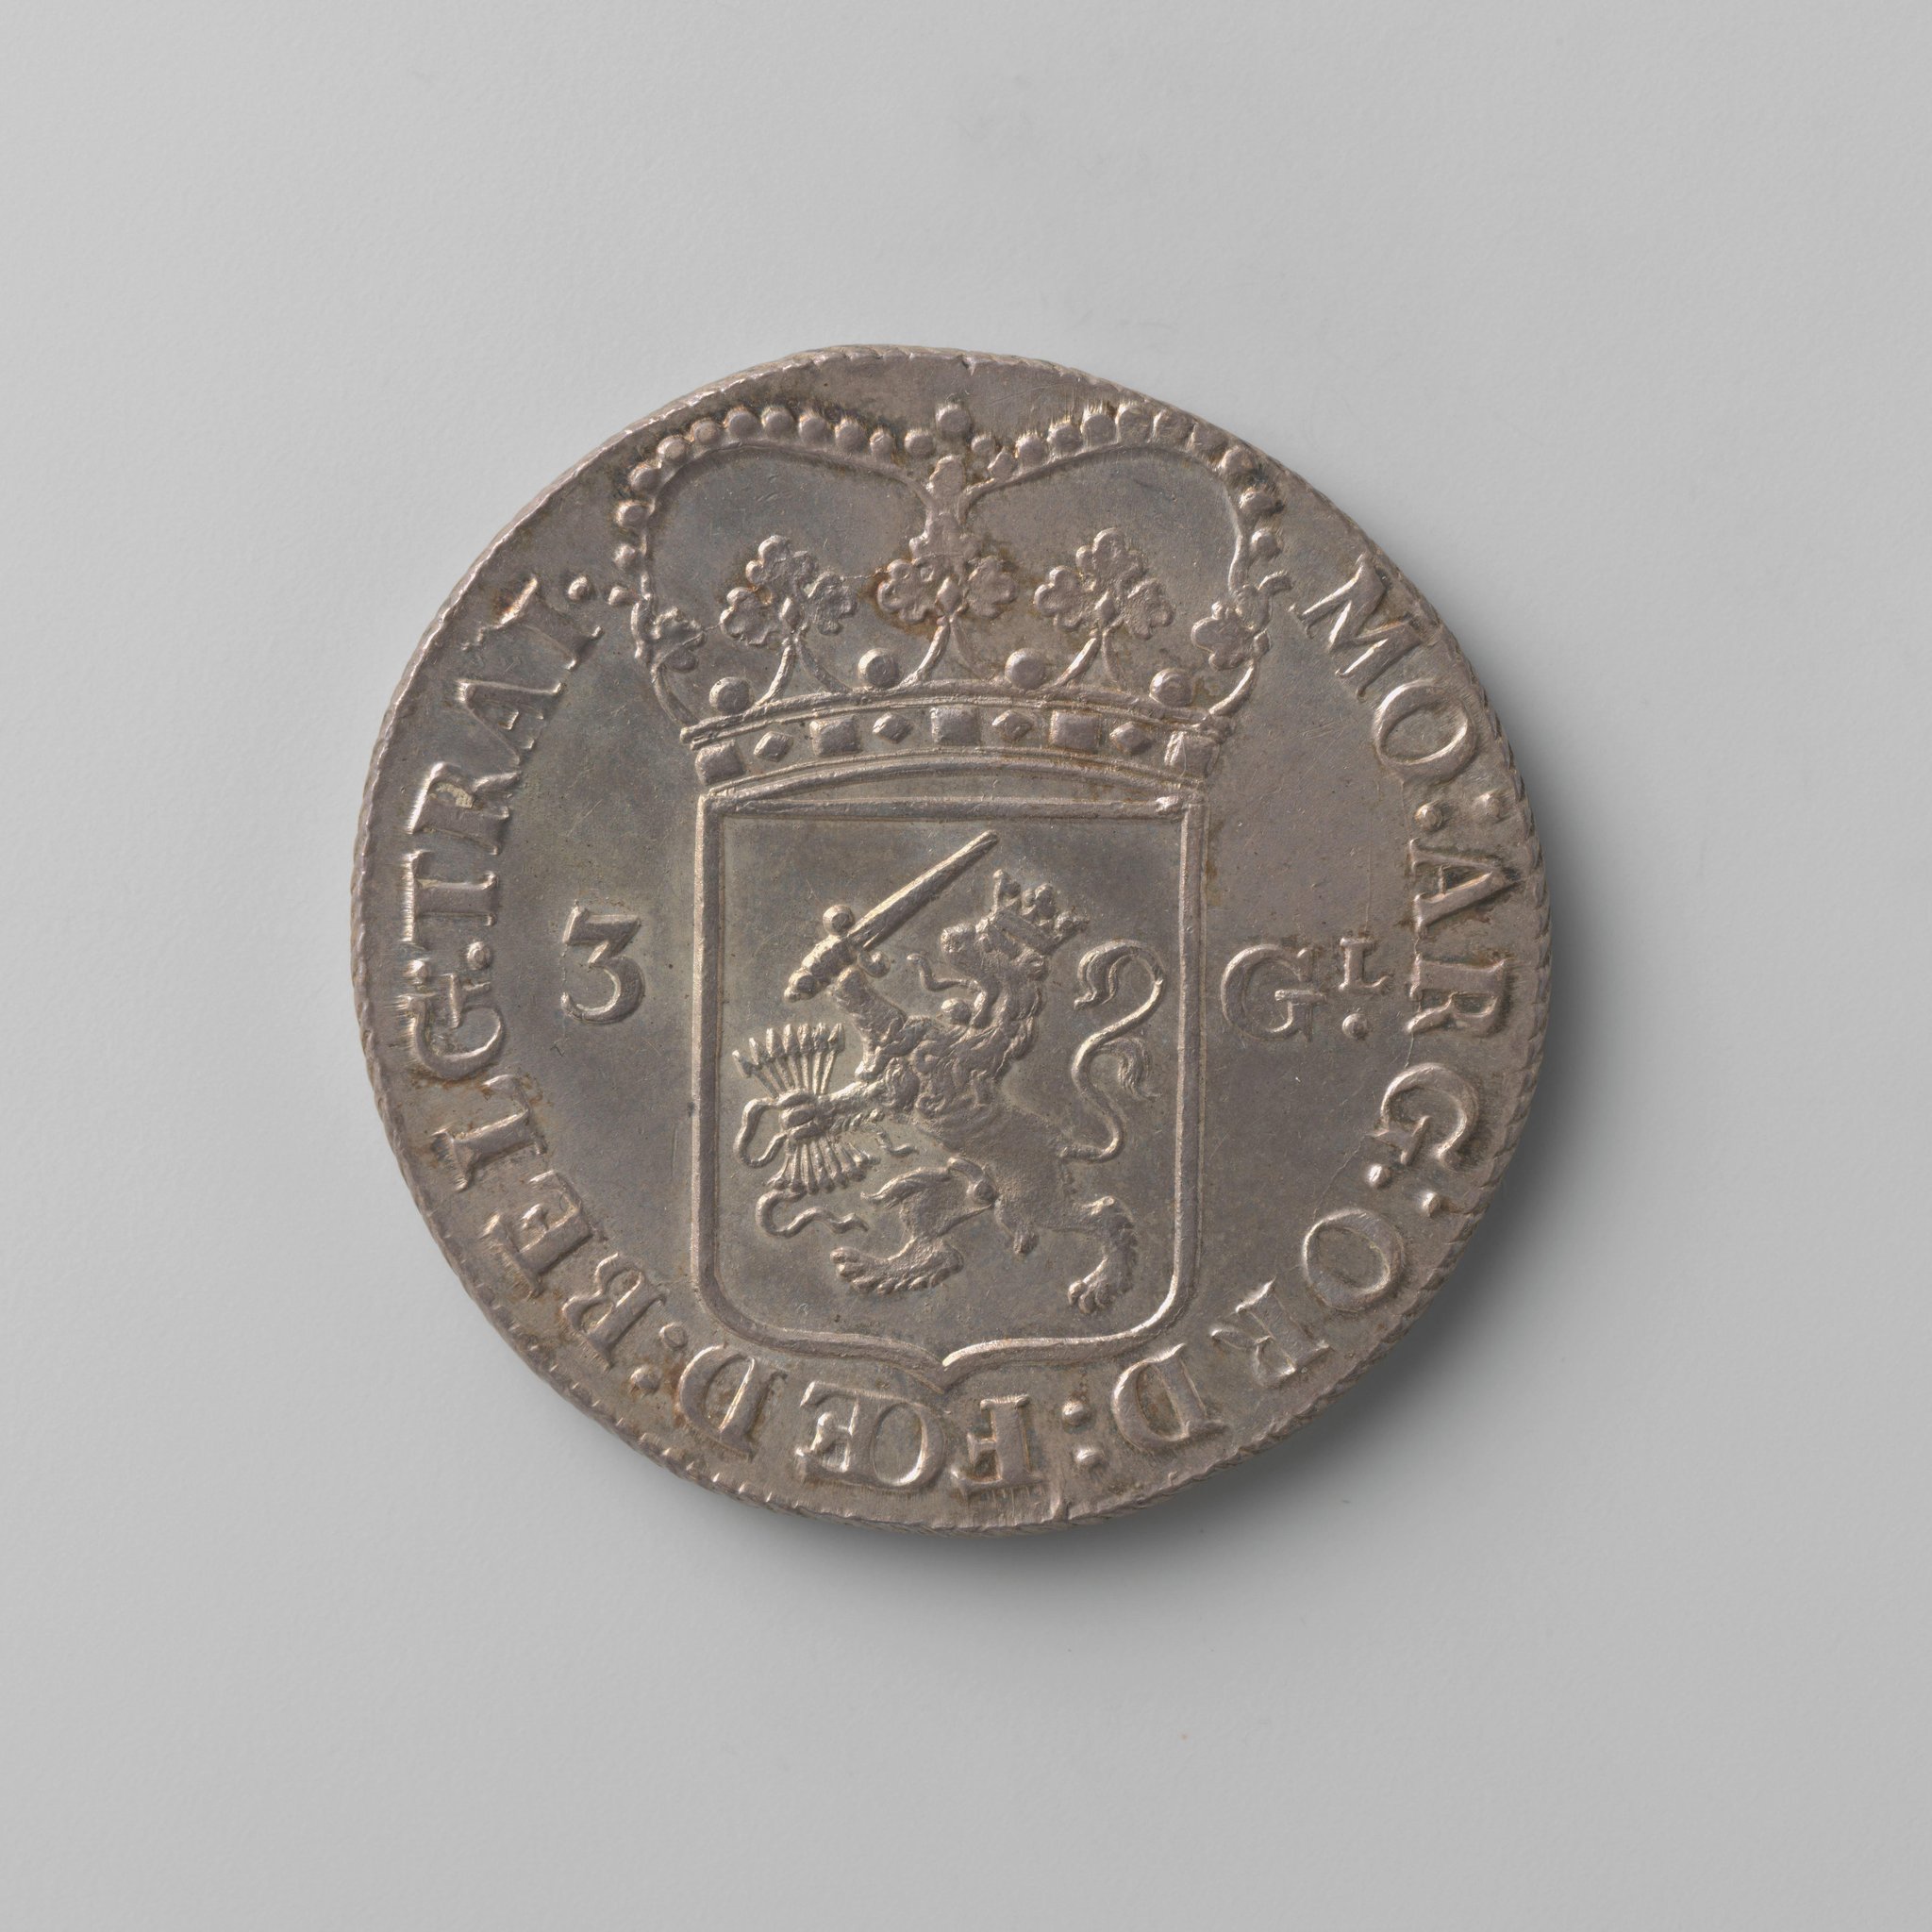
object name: coin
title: Utrechtse drie gulden, 1793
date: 1793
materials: silver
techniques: striking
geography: utrecht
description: Zilveren munt. Voorzijde: tussen waarde-aanduiding gekroond generaliteitswapenschild. Keerzijde: Nederlandse maagd met vrijheidshoed en speer, leunend op een bijbel op een altaar. In afsnede jaartal. Kabelrand.